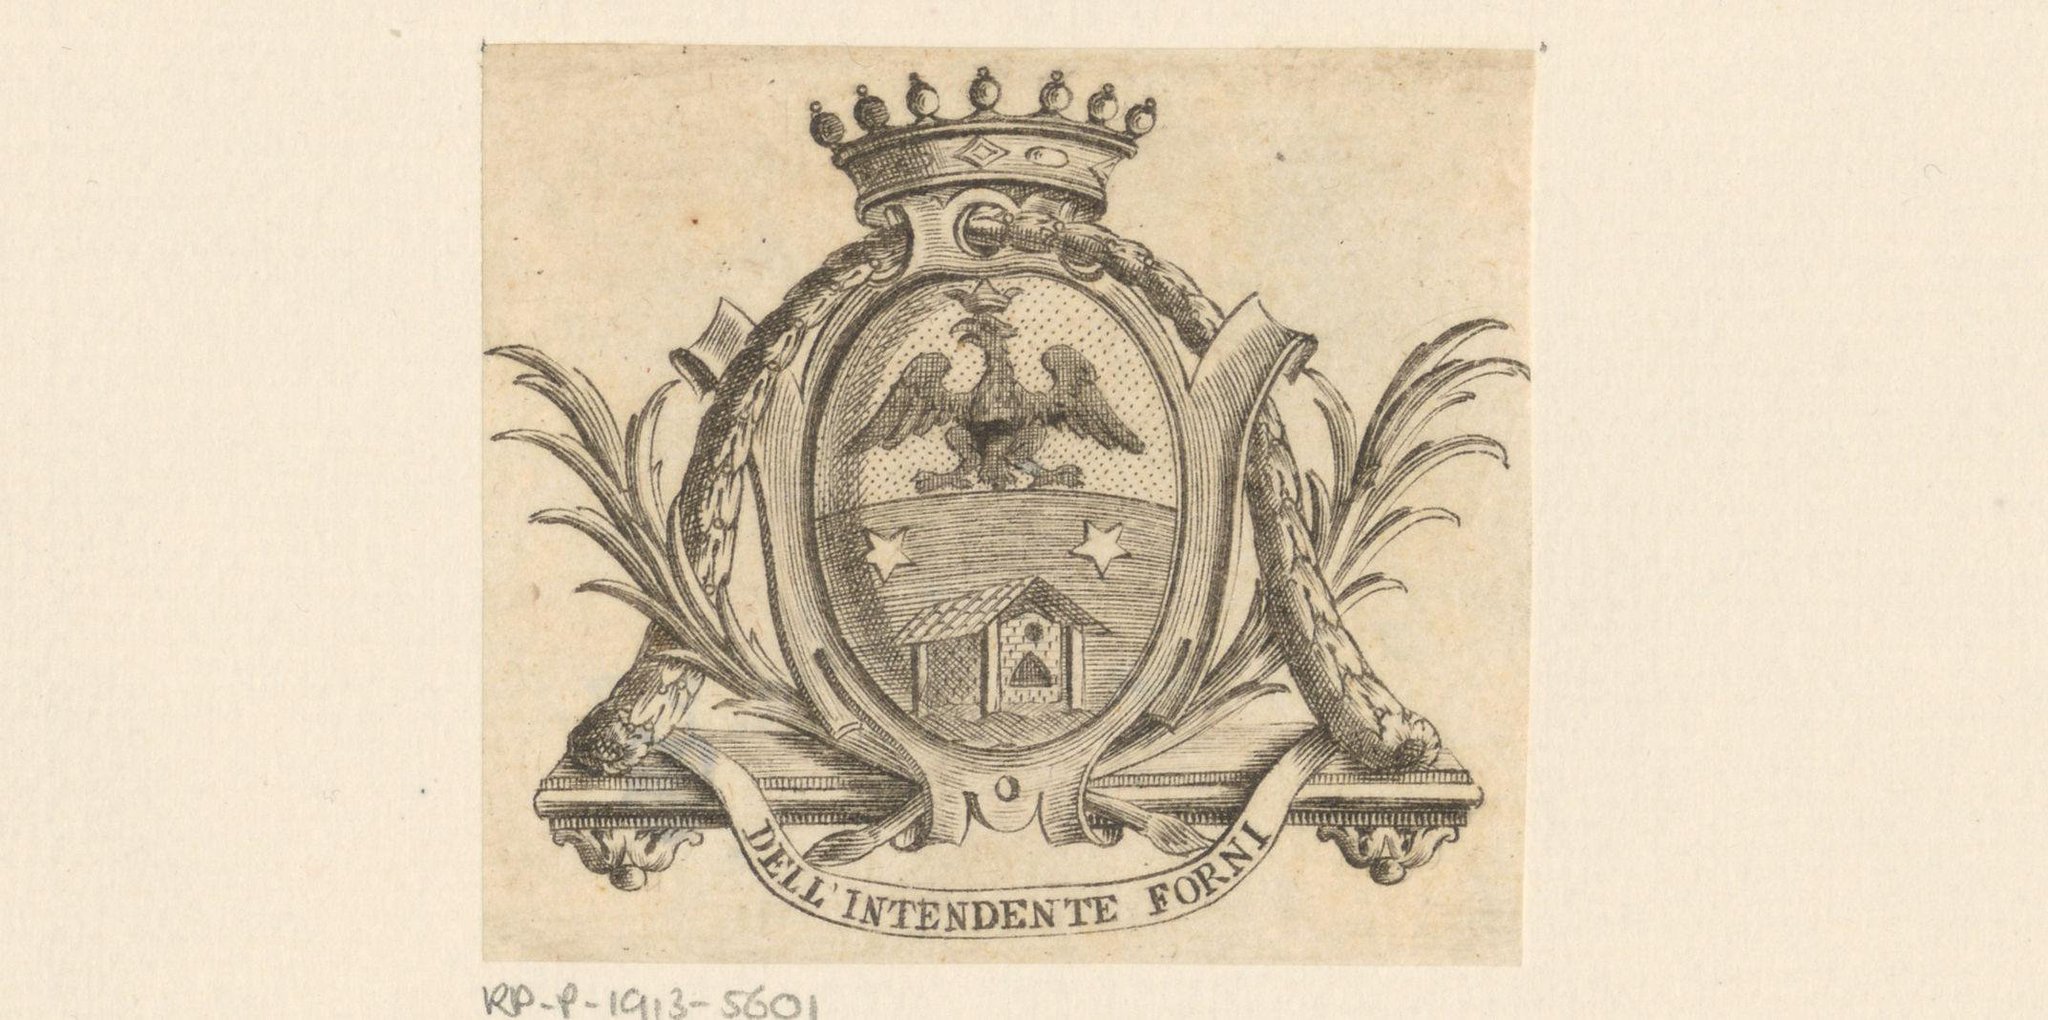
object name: bookplate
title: Ex libris van Forni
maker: Anonymous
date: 1600-1800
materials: paper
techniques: etching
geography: italy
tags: predatory birds: eagle, cottage, stars, armorial bearing, heraldry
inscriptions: collector's mark: Lugt 2760, collector's mark: Lugt 2233, stamp